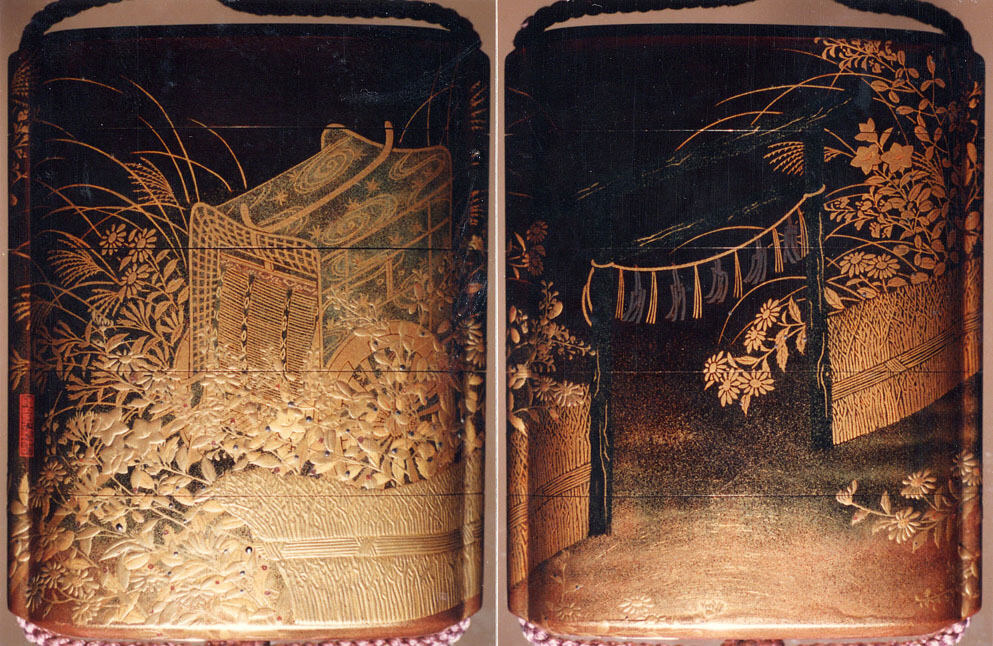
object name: inrō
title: Case (Inrō) with Design of Nonomiya (Shrine in the Fields), from The Tale of Genji, chapter 10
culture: japanese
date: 1801-1833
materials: bronze, gold, lacquer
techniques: carving, inlay, maki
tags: flowers